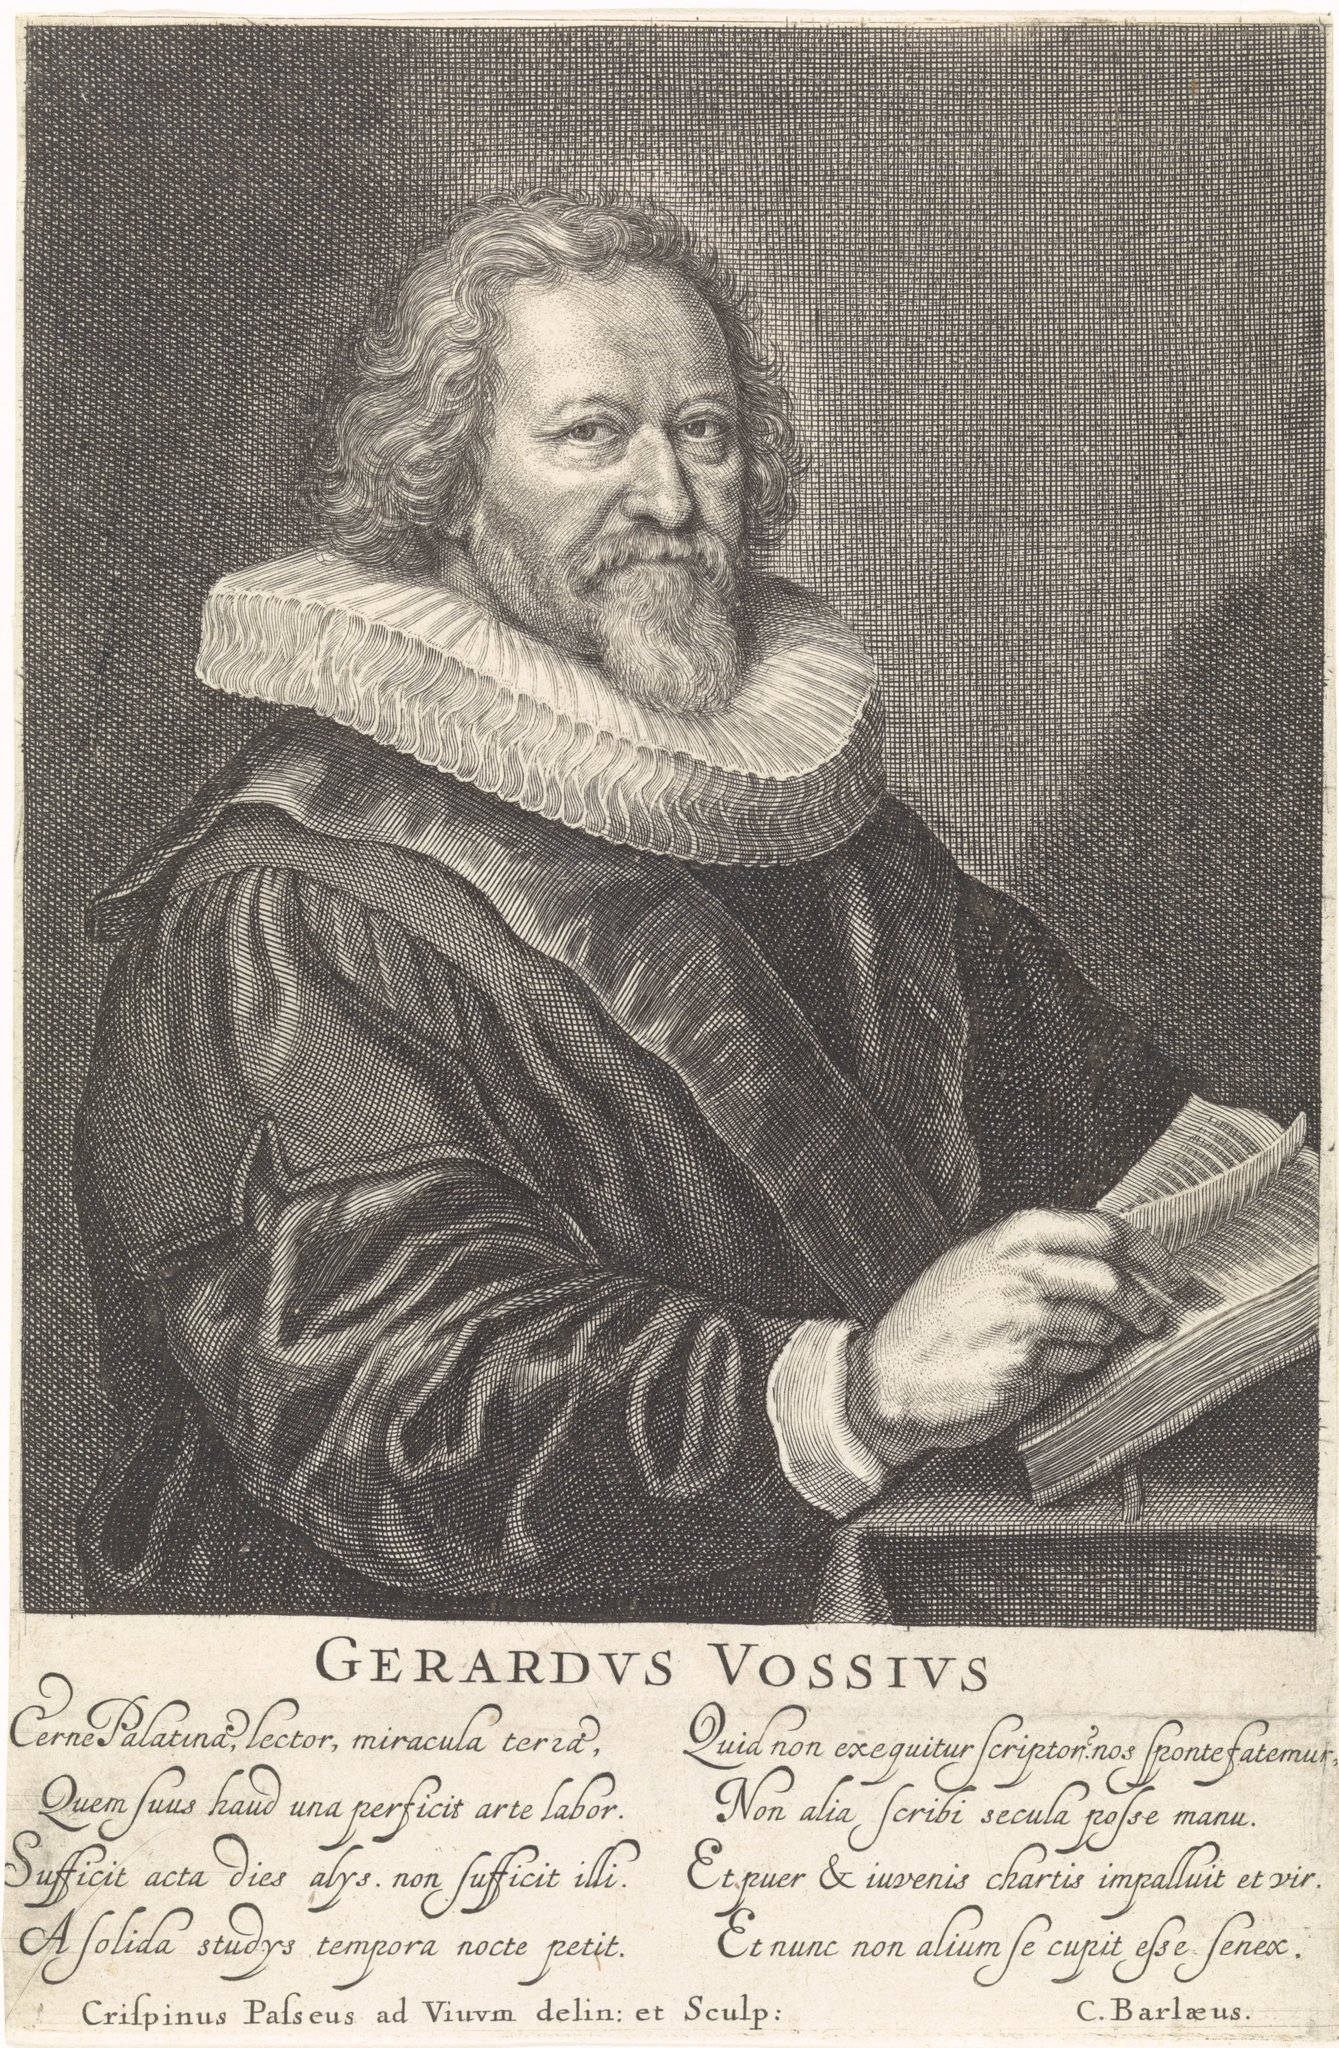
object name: print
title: Portret van Gerardus Joannes Vossius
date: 1639-1670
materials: paper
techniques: engraving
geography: amsterdam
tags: amsterdam, gerardus joannes vossius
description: Portret van de theoloog en schrijver Gerardus Joannes Vossius. In de marge een achtregelig lofdicht, in twee kolommen, in het Latijn.